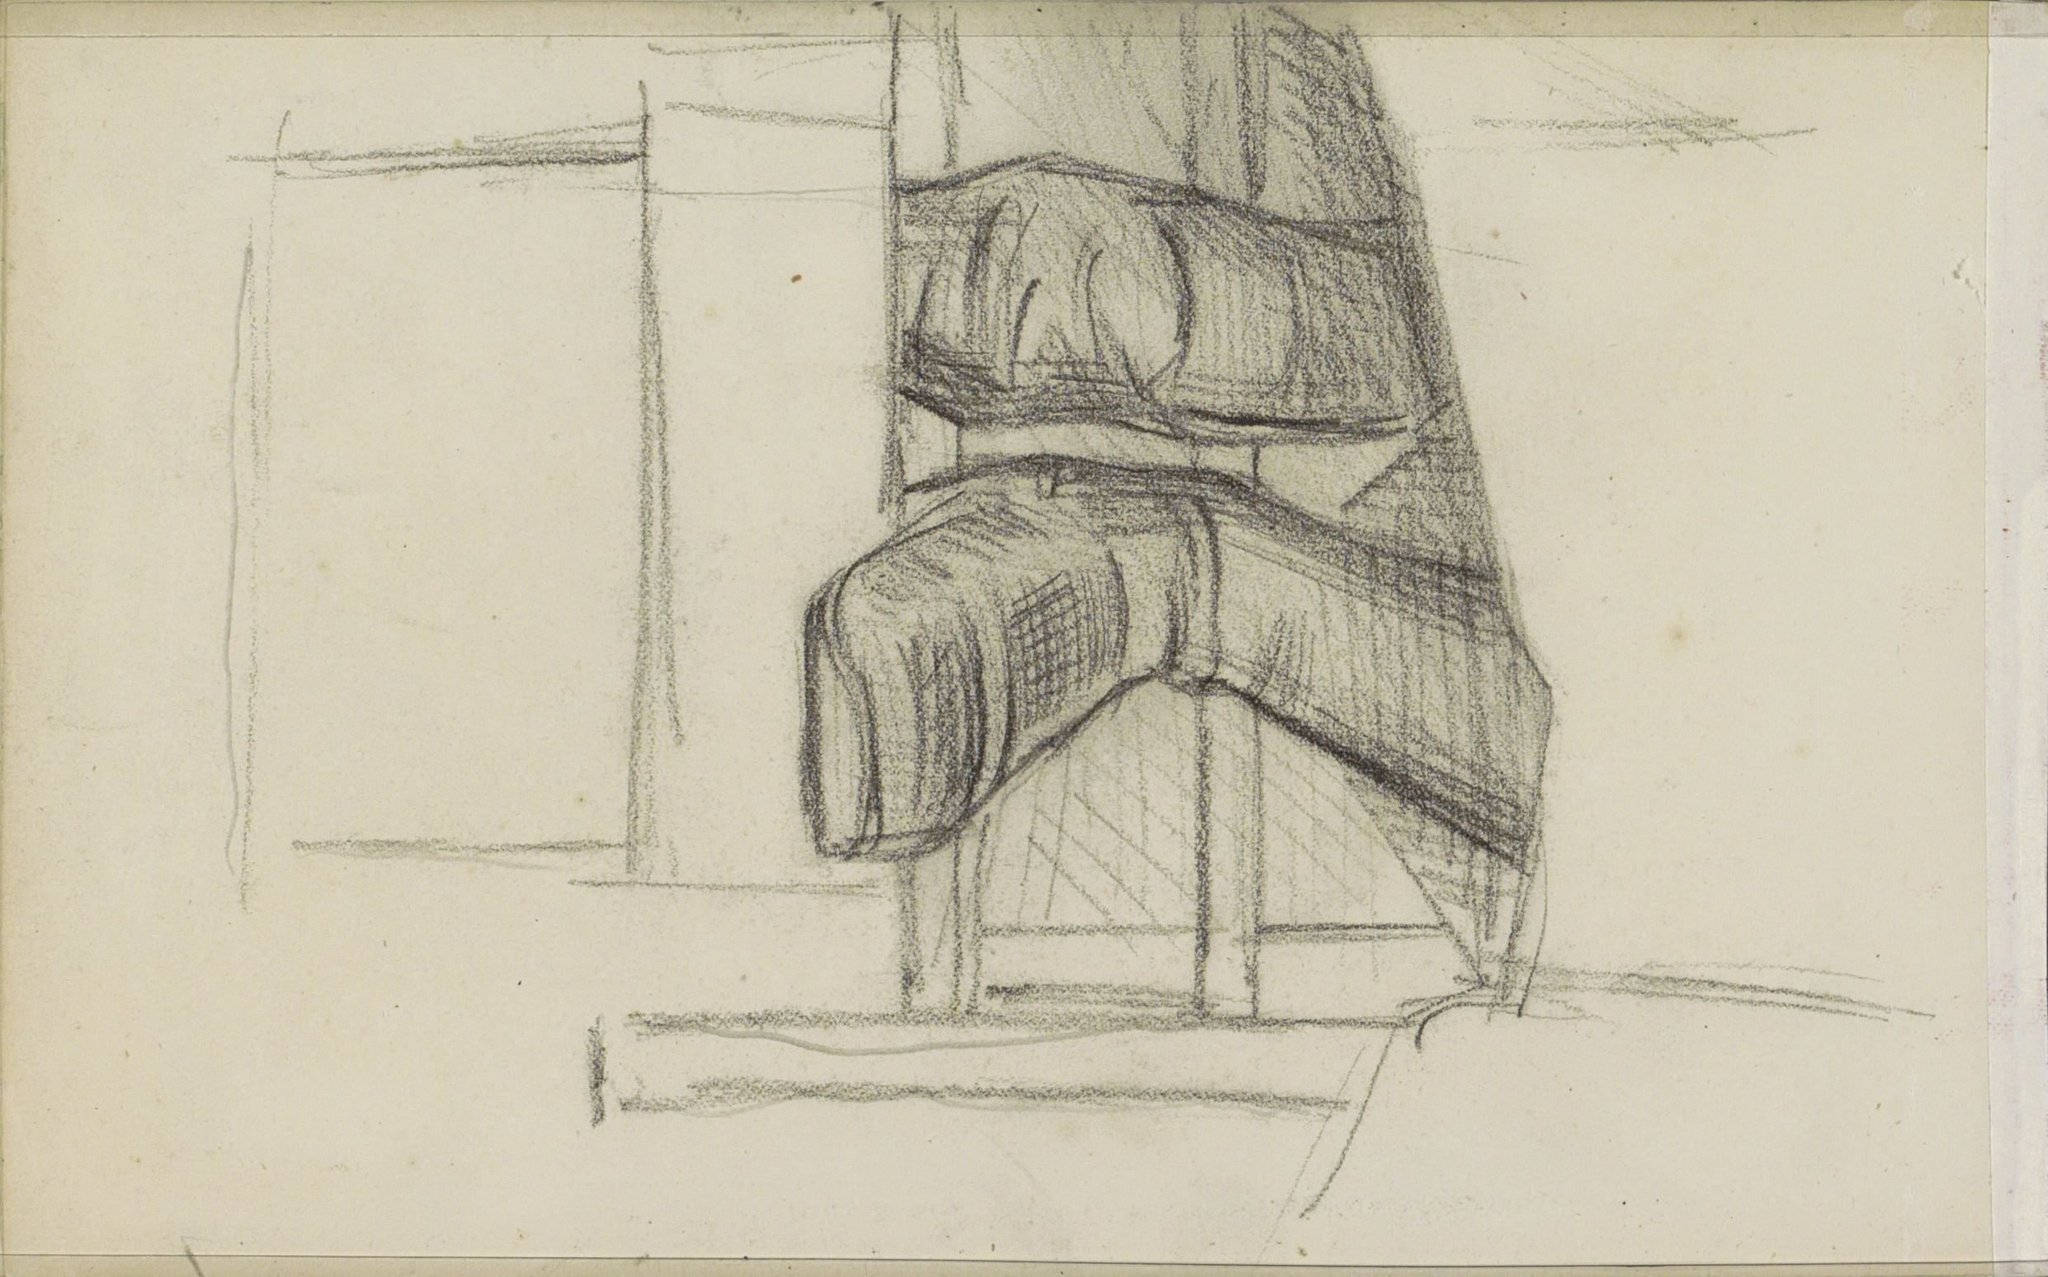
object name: sketchbook leaf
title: Voeten op een stoof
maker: jozef israëls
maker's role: draughtsman, painter, print maker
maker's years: 1824-1911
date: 1834-1911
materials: chalk, paper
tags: footstool, wooden shoes, clogs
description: De figuur draagt klompen. Blad 37 verso uit een schetsboek met 37 bladen.